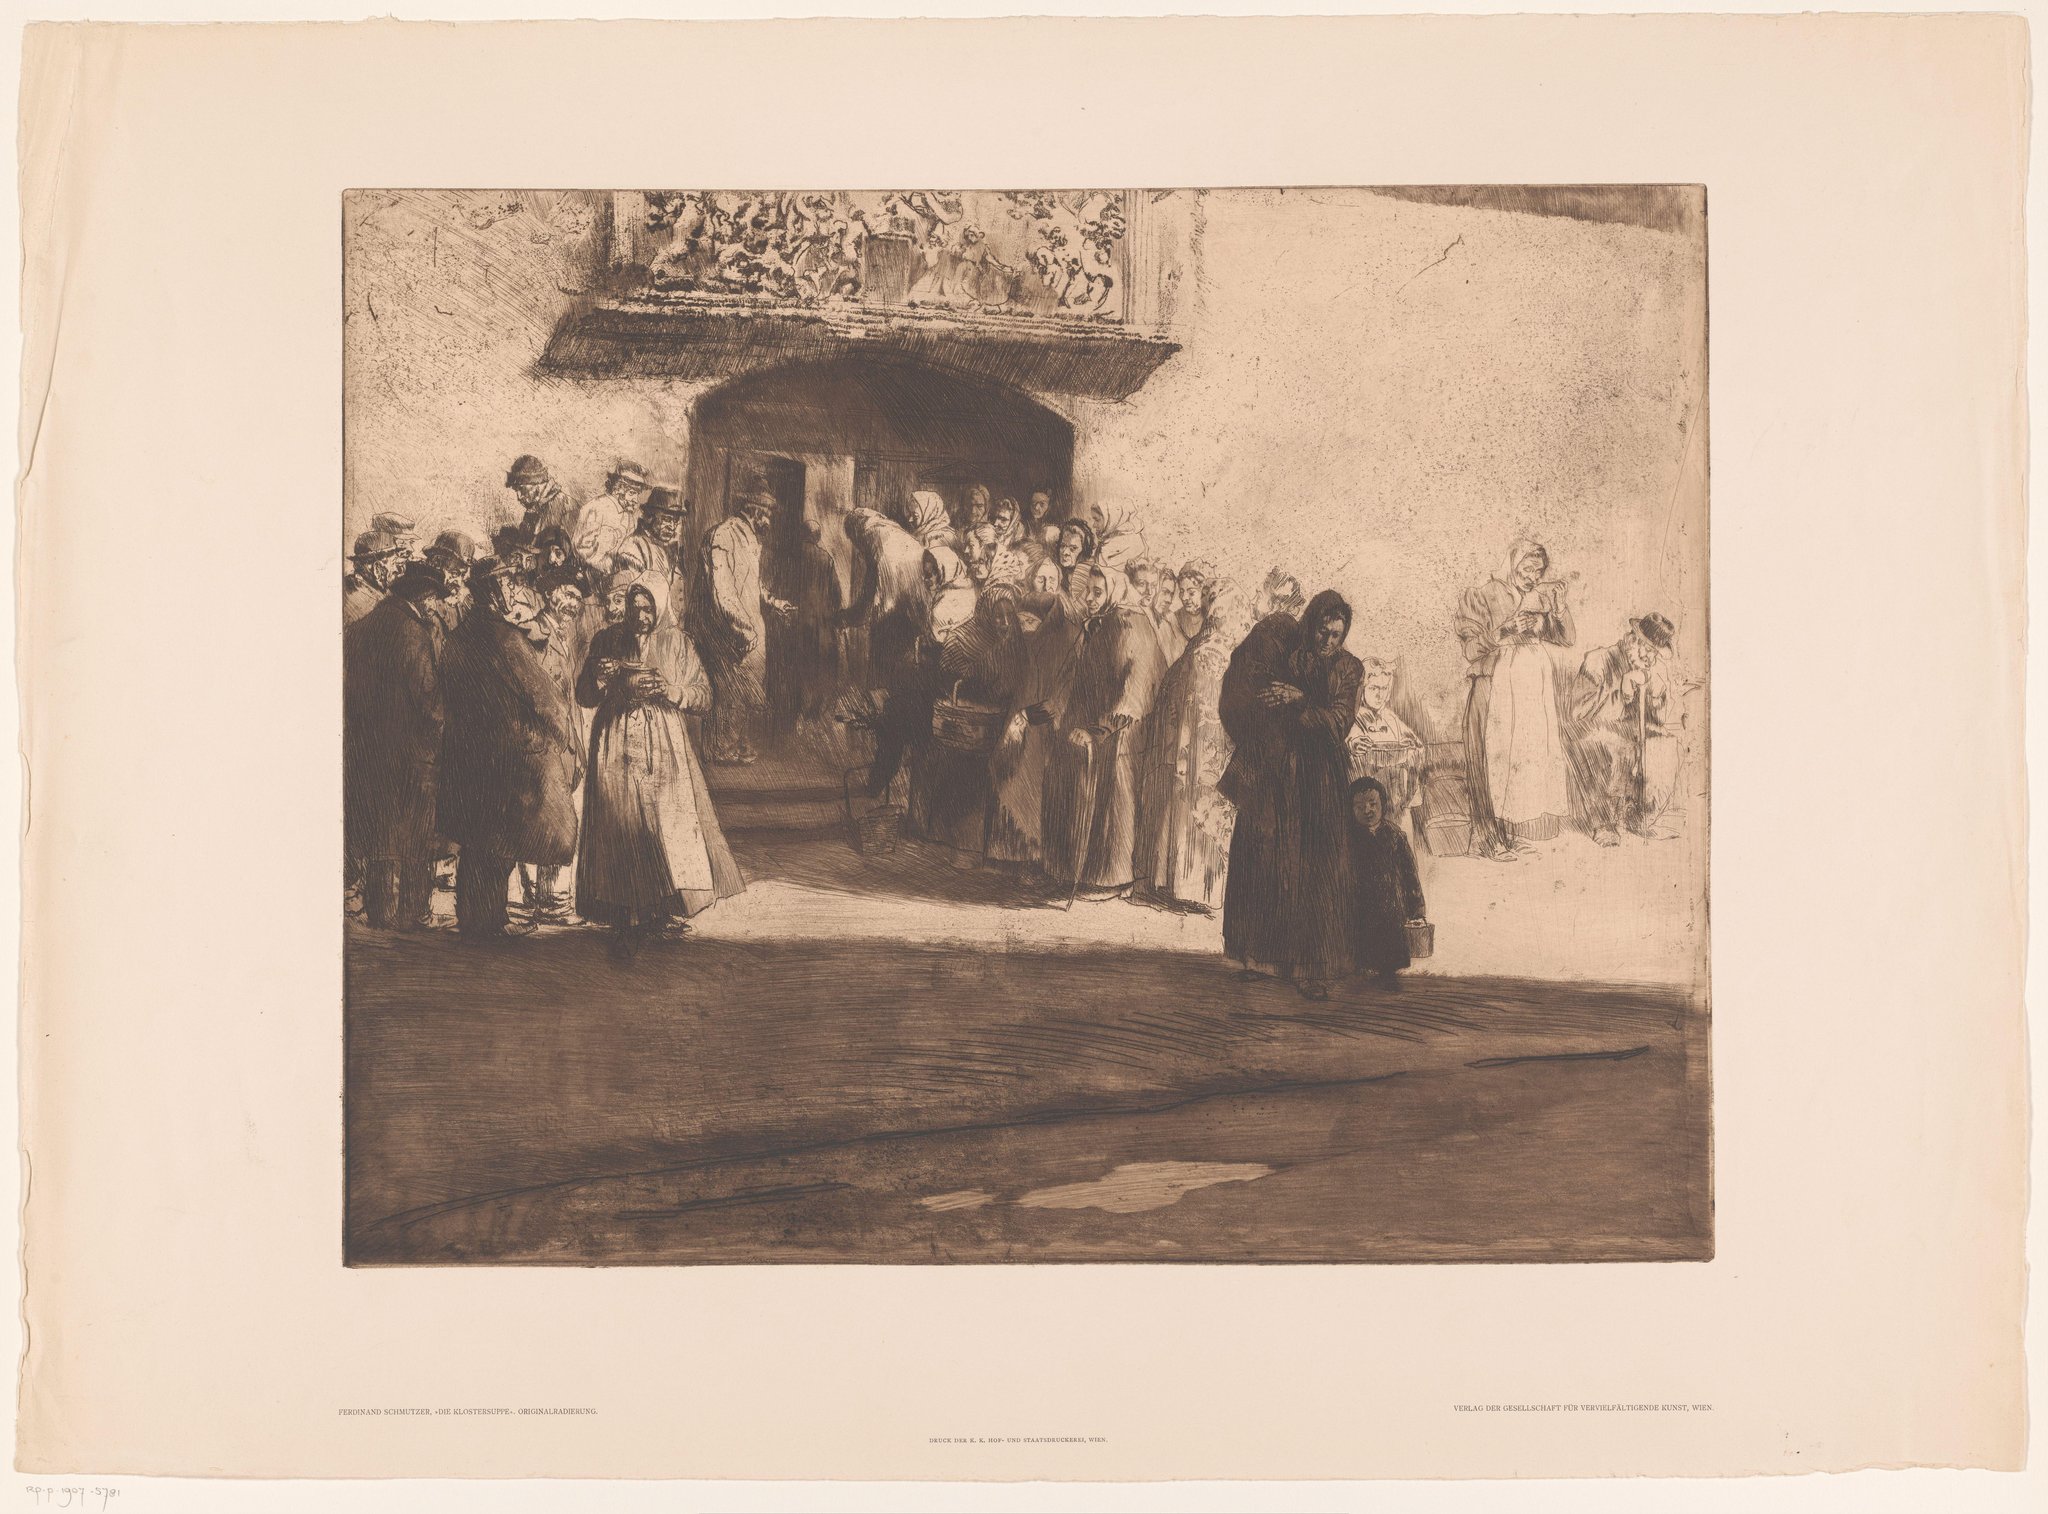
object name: print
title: Die Klostersuppe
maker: ferdinand schmutzer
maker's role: painter, print maker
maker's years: 1870-1928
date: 1880-1907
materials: paper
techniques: aquatint, drypoint, etching, roulette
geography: vienna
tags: soup-kitchen, cook-shop, the poor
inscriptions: collector's mark: Lugt 2166